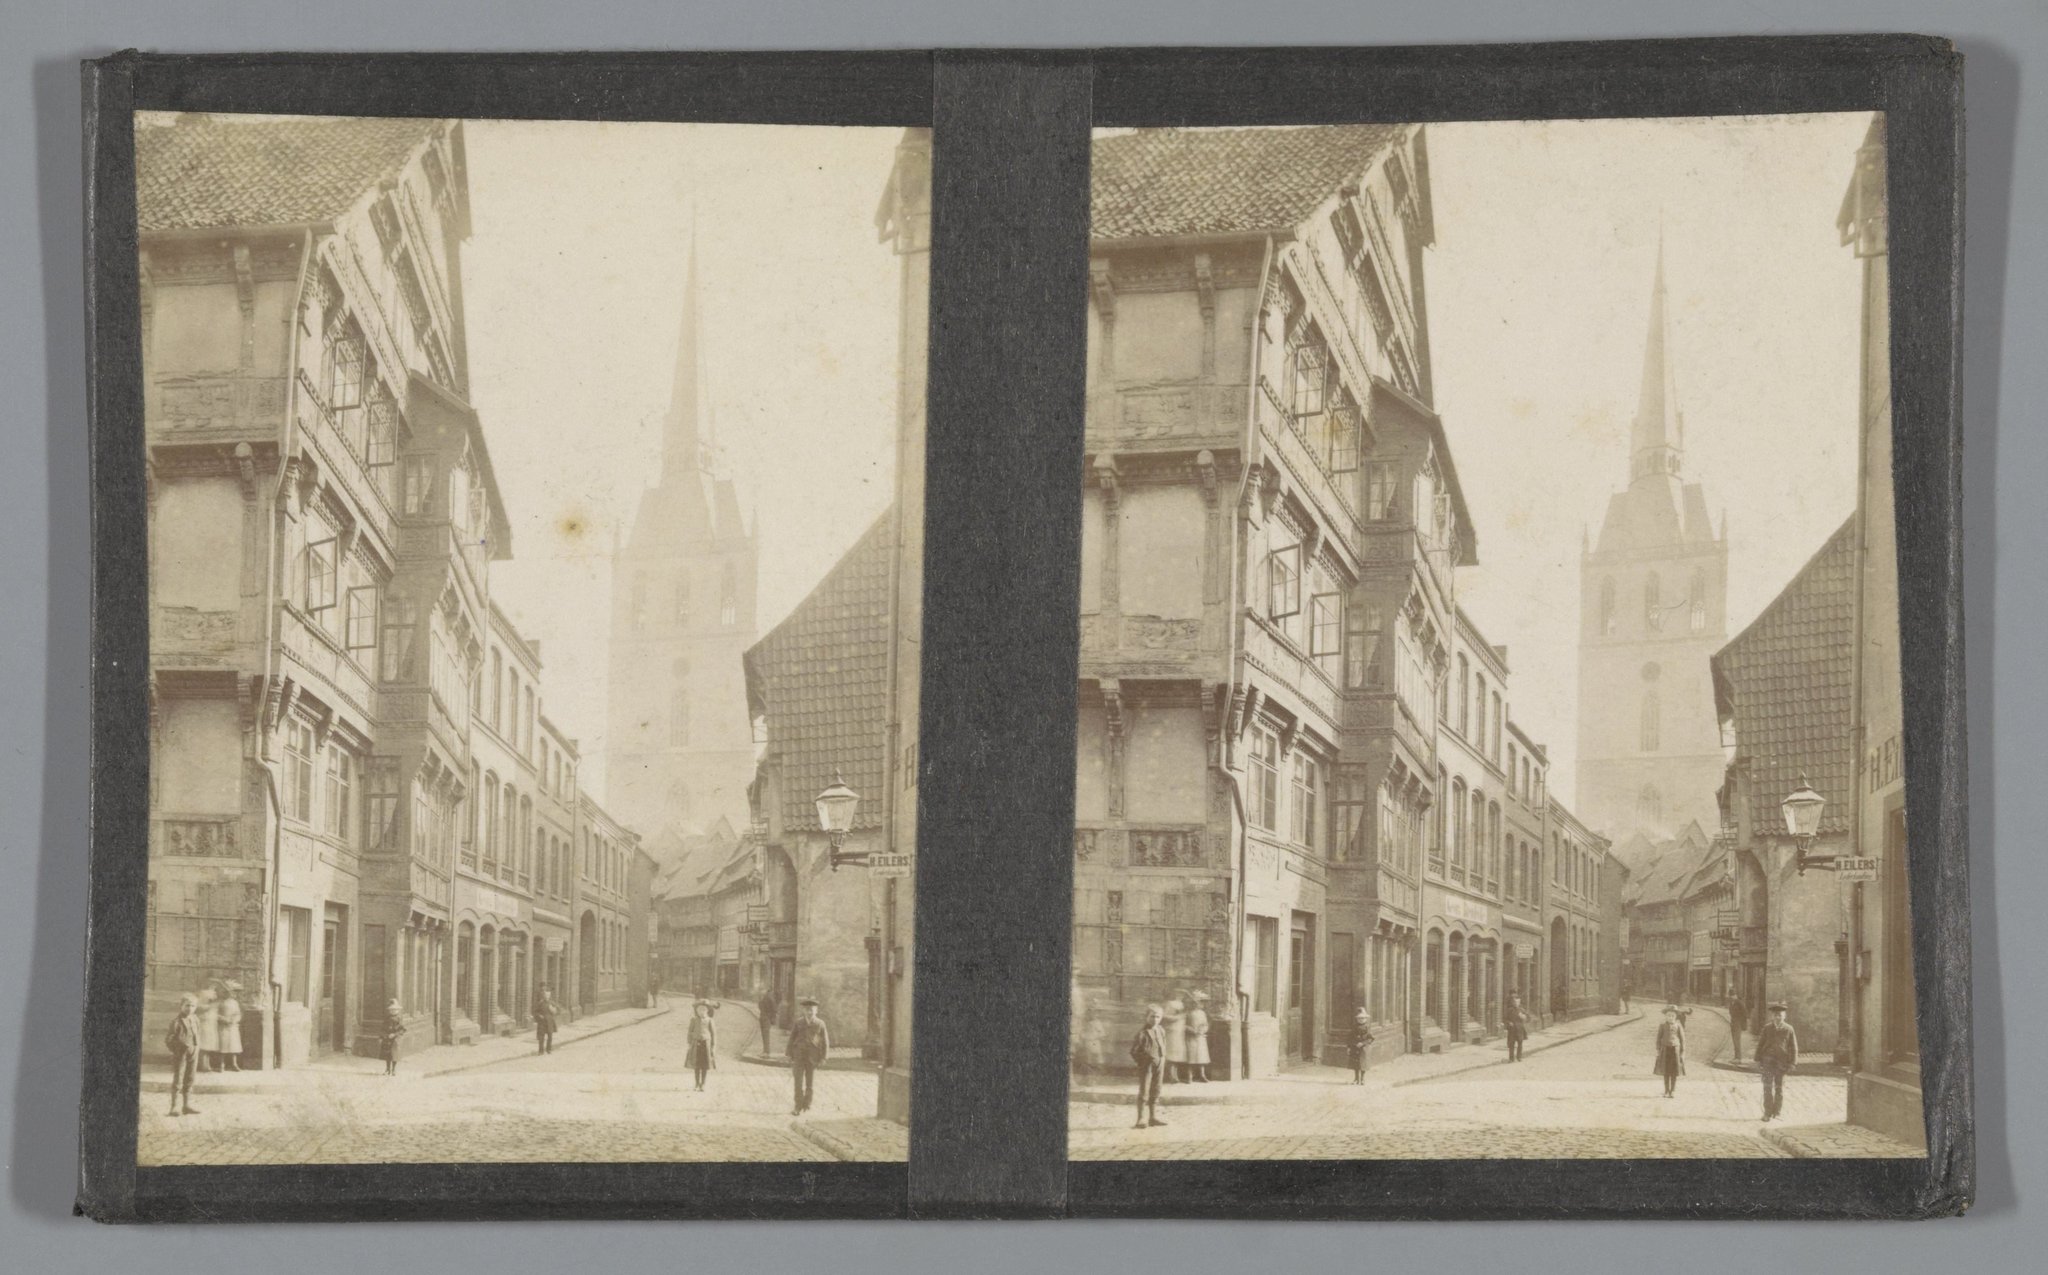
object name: stereograph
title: Straatbeeld met toren van de Sint-Andreaskerk in Hildesheim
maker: Anonymous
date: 1883-1900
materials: cardboard, paper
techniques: albumen print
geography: hildesheim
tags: tower, clock tower ~ monumental adornment, street